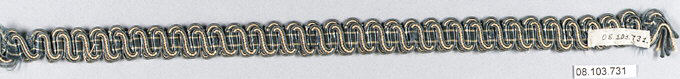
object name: gimp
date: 1834-1866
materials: silk